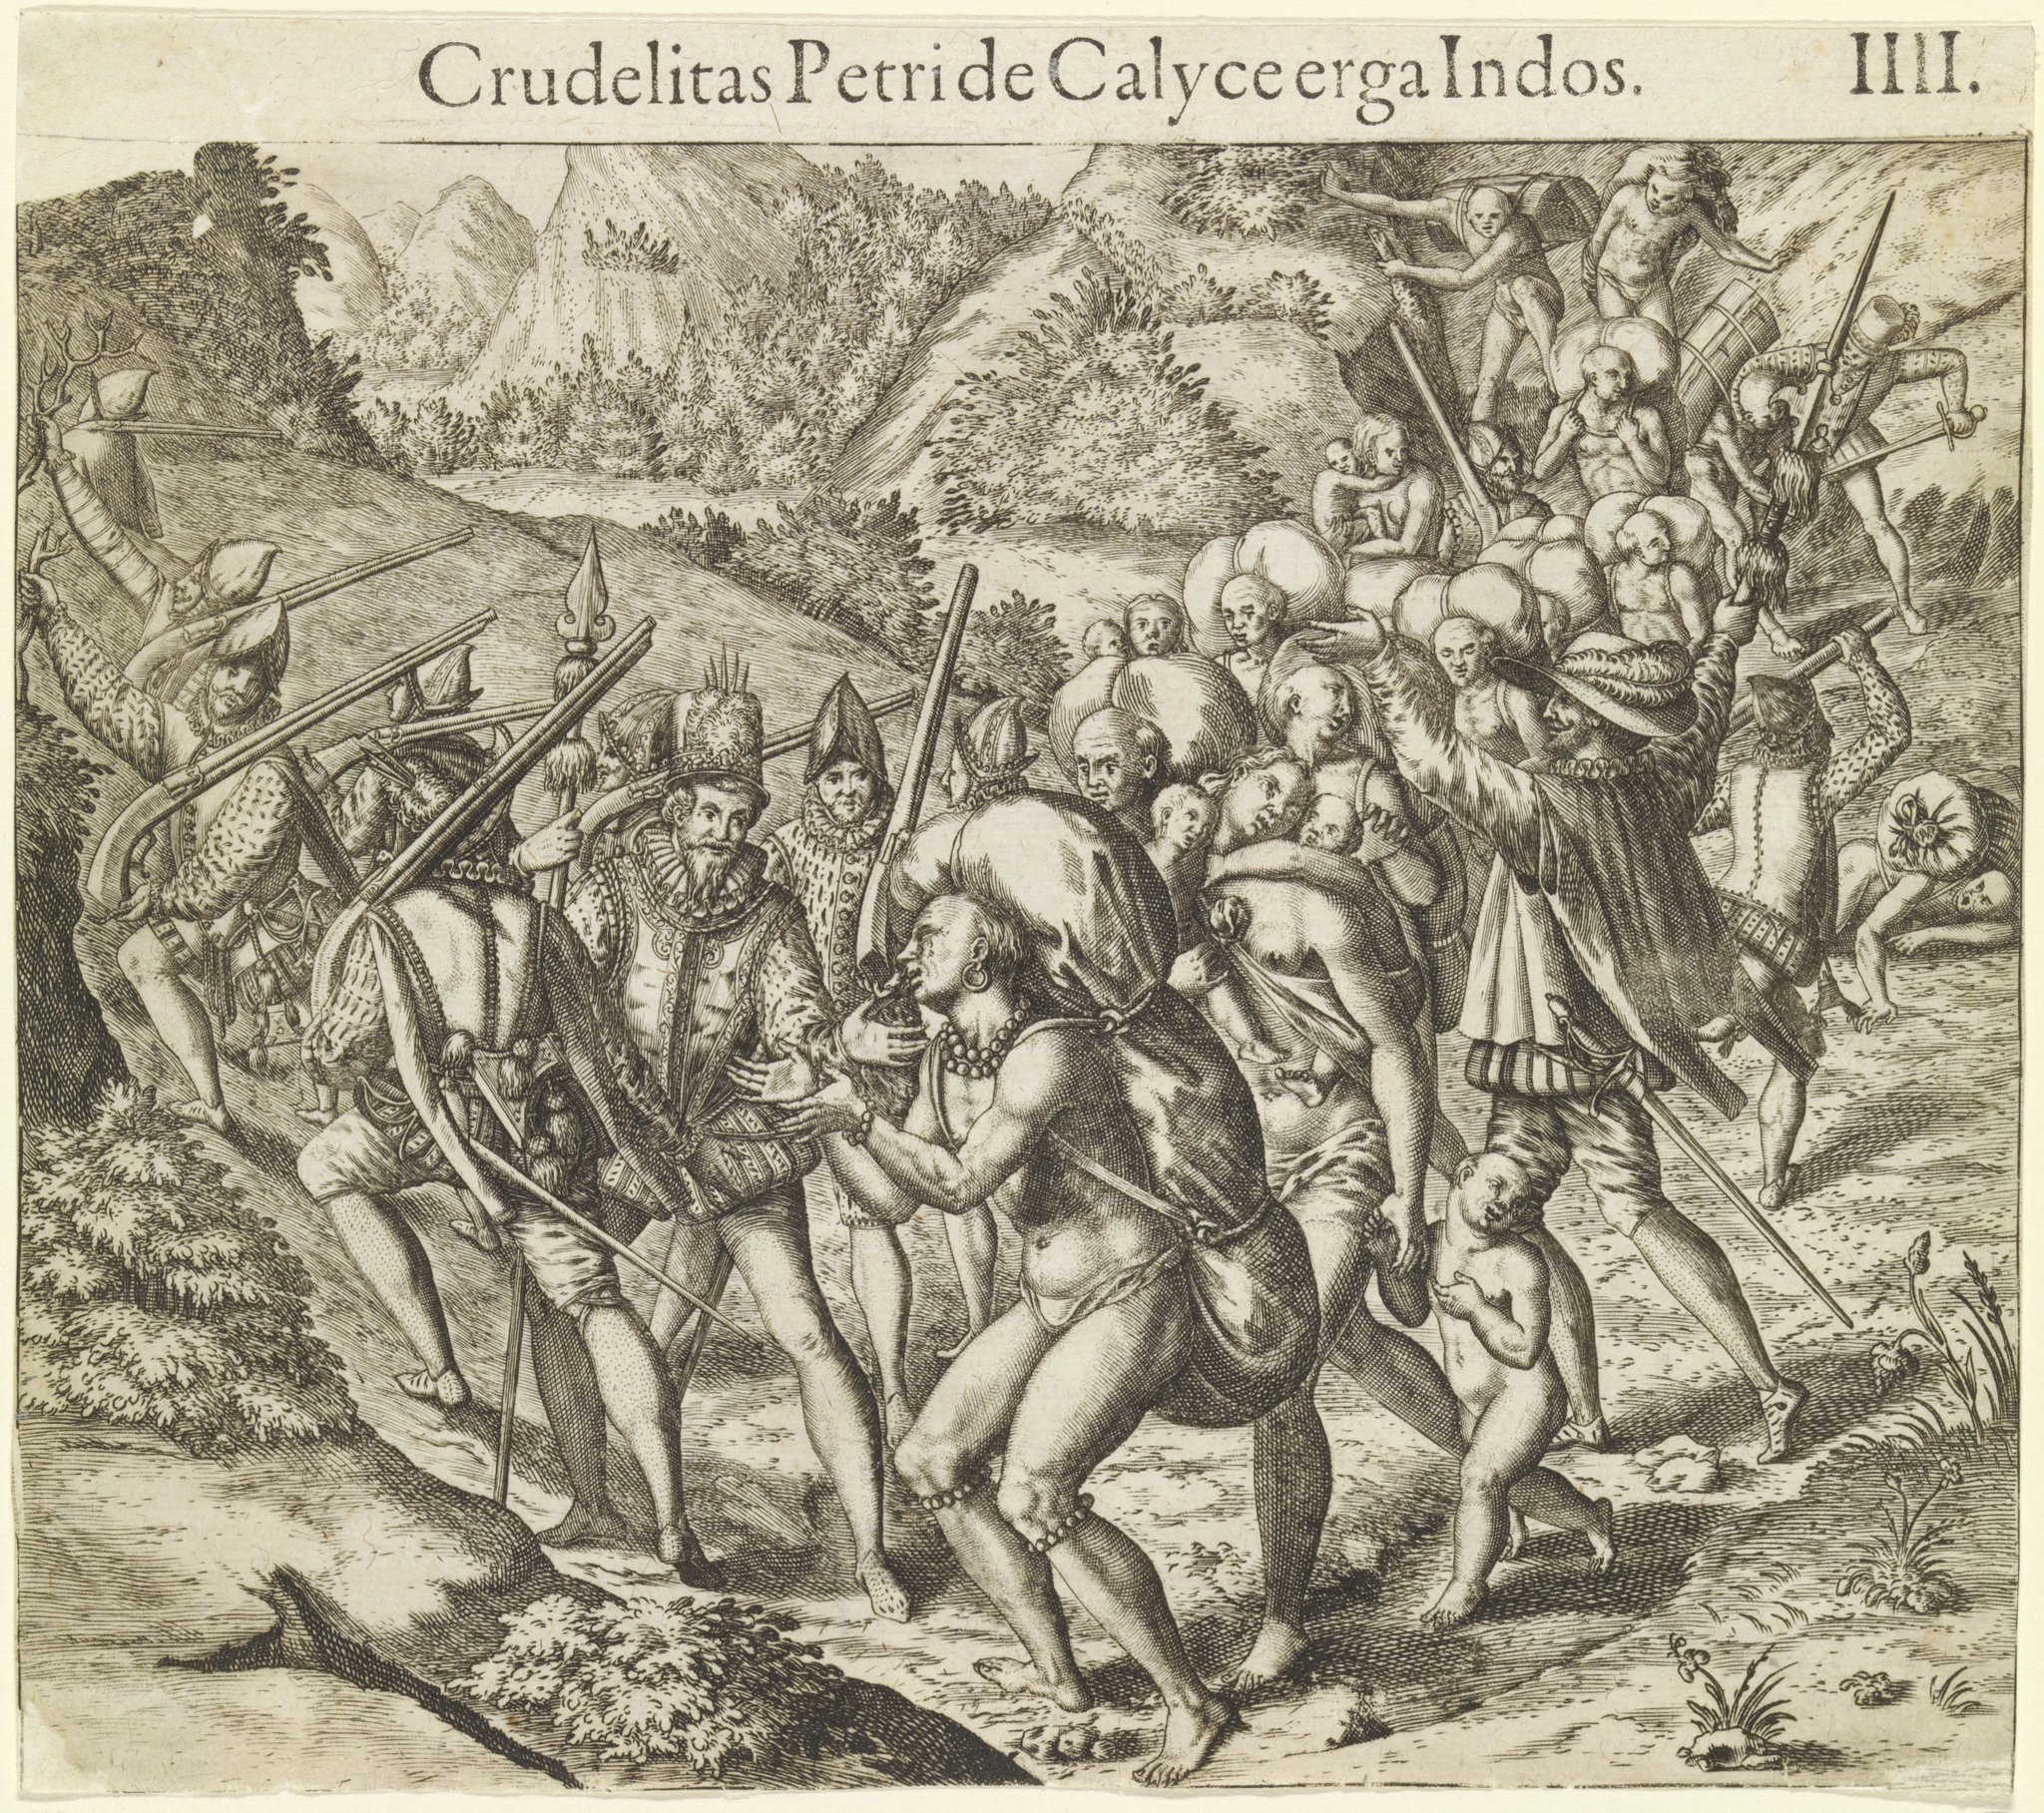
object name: book illustration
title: Groep Indianen wordt door Westerlingen gevangen genomen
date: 1594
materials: paper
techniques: engraving, letterpress printing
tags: law and jurisprudence (+ transport), indigenous peoples of south america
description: Een groep oorspronkelijke bewoners van Zuid-Amerika, bestaande uit mannen, vrouwen en kinderen, wordt door Europeanen gevangengenomen en afgevoerd. De lokale bevolking draagt bagage op hun rug. De Europeanen zijn gewapend met musketten, zwaarden en knuppels.